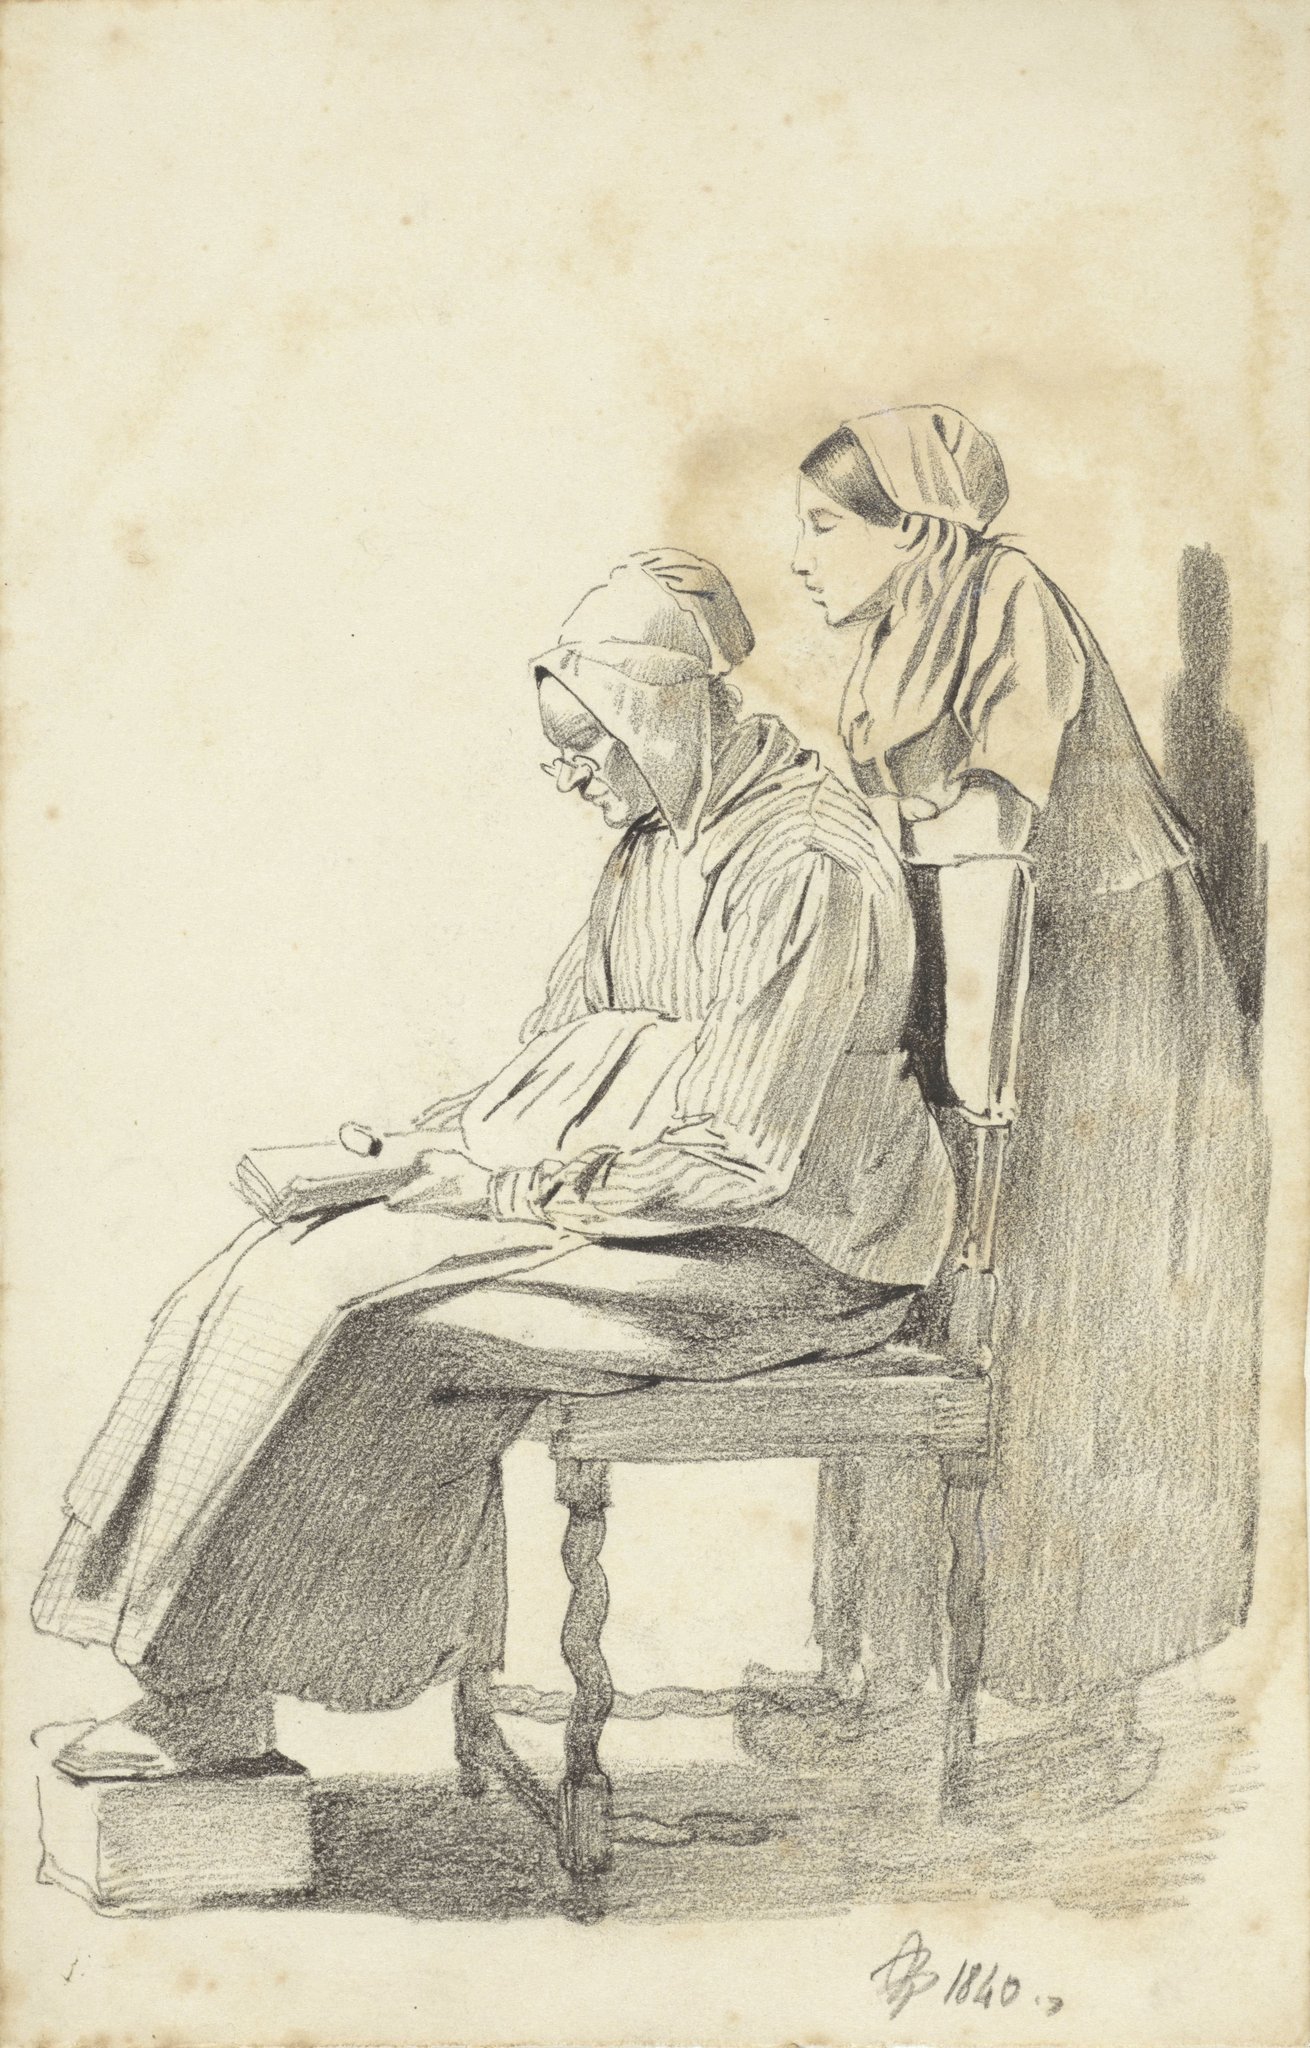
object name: drawing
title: Jonge vrouw staande achter een zittende lezende oude vrouw, van opzij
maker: pieter van loon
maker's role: draughtsman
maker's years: 1801-1873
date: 1840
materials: paper, pencil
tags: reading